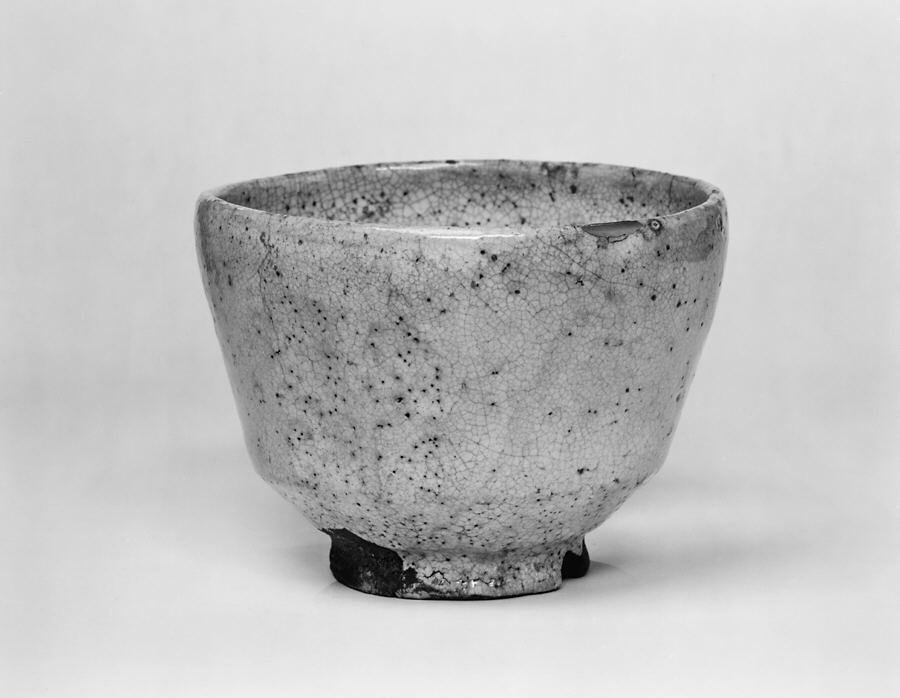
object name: teabowl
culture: japanese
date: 1601-1700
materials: ceramic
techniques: glazing